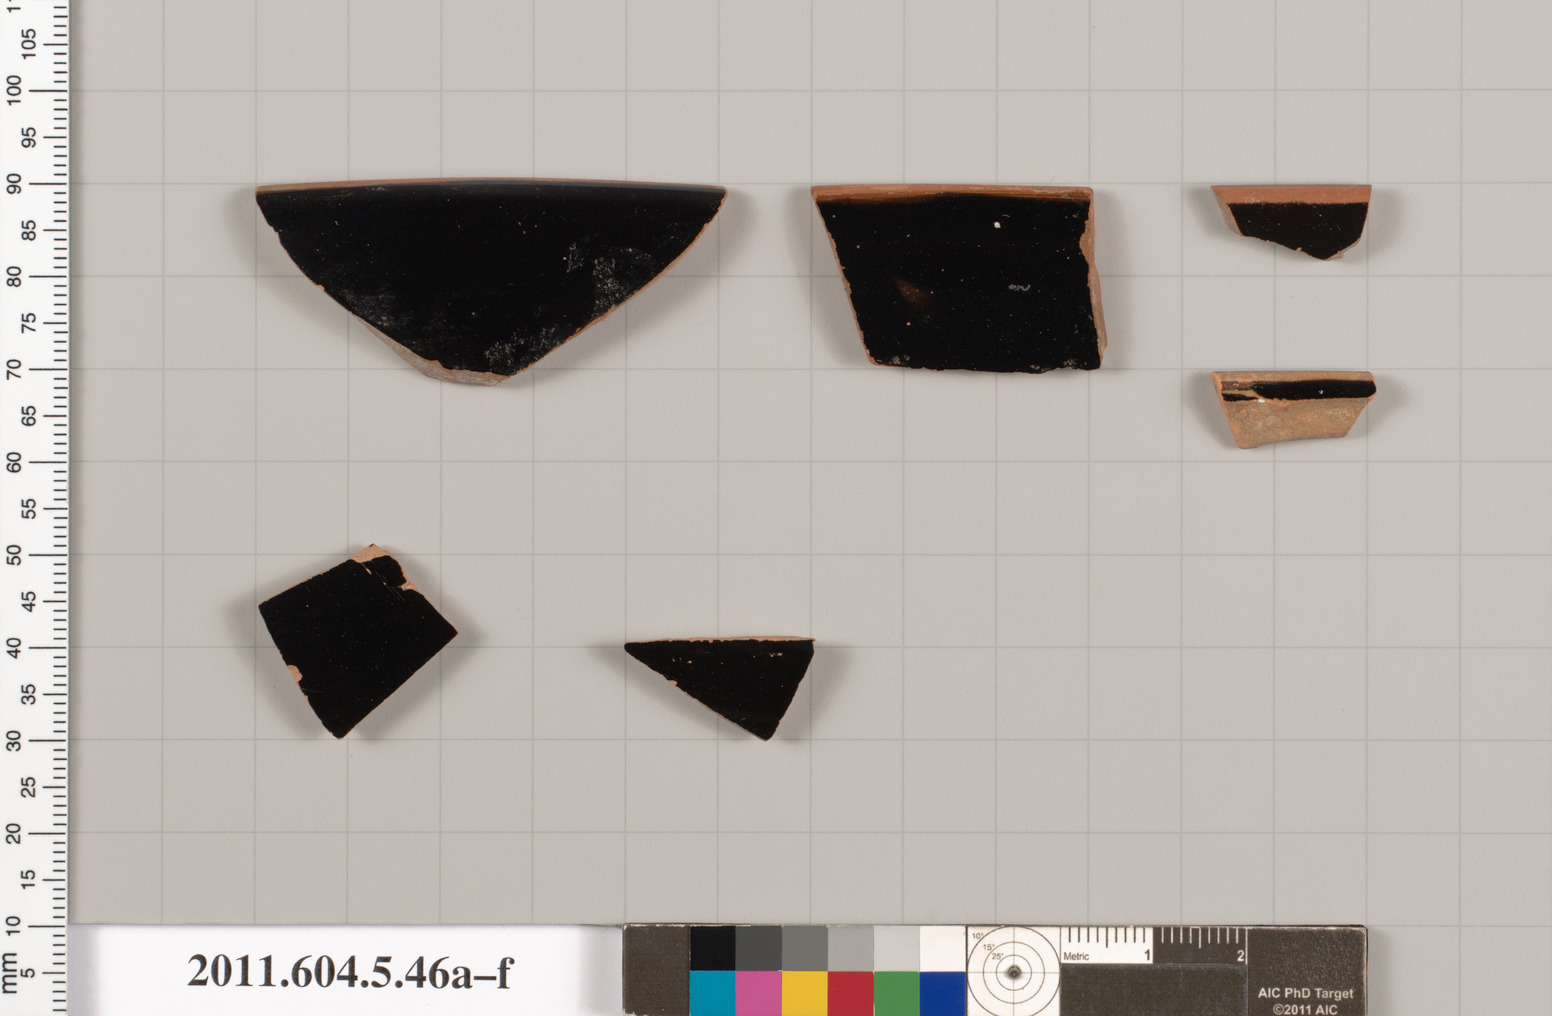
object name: kylix fragment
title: Terracotta fragments of kylikes (drinking cups)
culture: greek, attic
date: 500-480 BCE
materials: terracotta